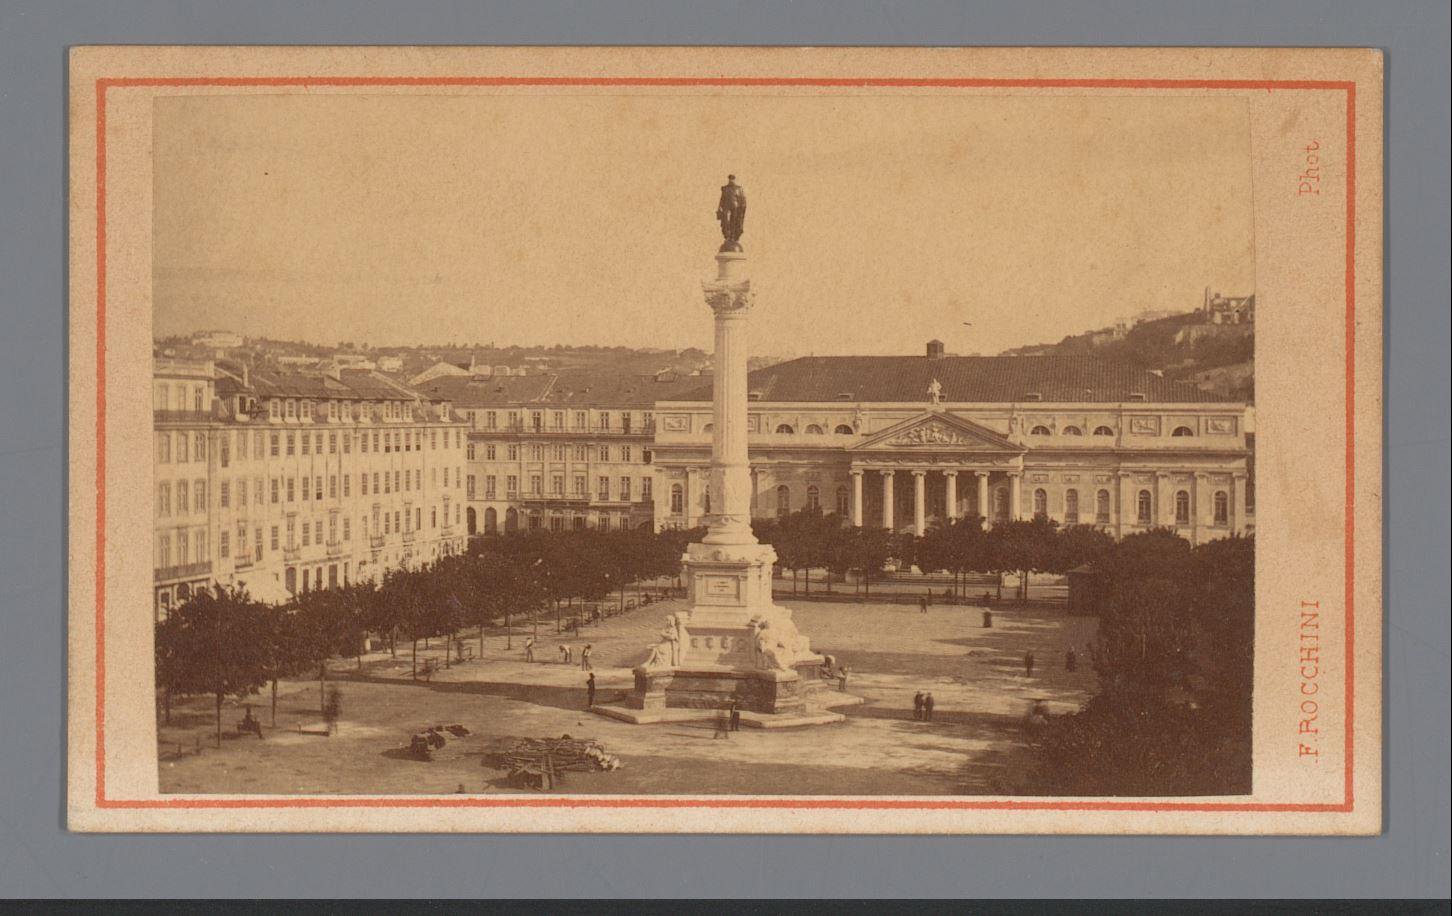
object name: carte de visite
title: Standbeeld van Peter I van Brazilië op het Pedro IV-plein in Lissabon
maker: francisco rocchini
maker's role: fotograaf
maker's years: 1822-1895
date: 1855-1890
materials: cardboard, paper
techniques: albumen print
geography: lisbon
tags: square, place, circus, etc., monument, statue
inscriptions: inscription: ‘Travessa da Água de Flor N.º 1 - 2.º andar/ defronte da Torre de S. Roque/ LISBOA/ Encarrega-se de fazer todos os objectos p.a Photographia.’, inscription: ‘DEPOSITADA’